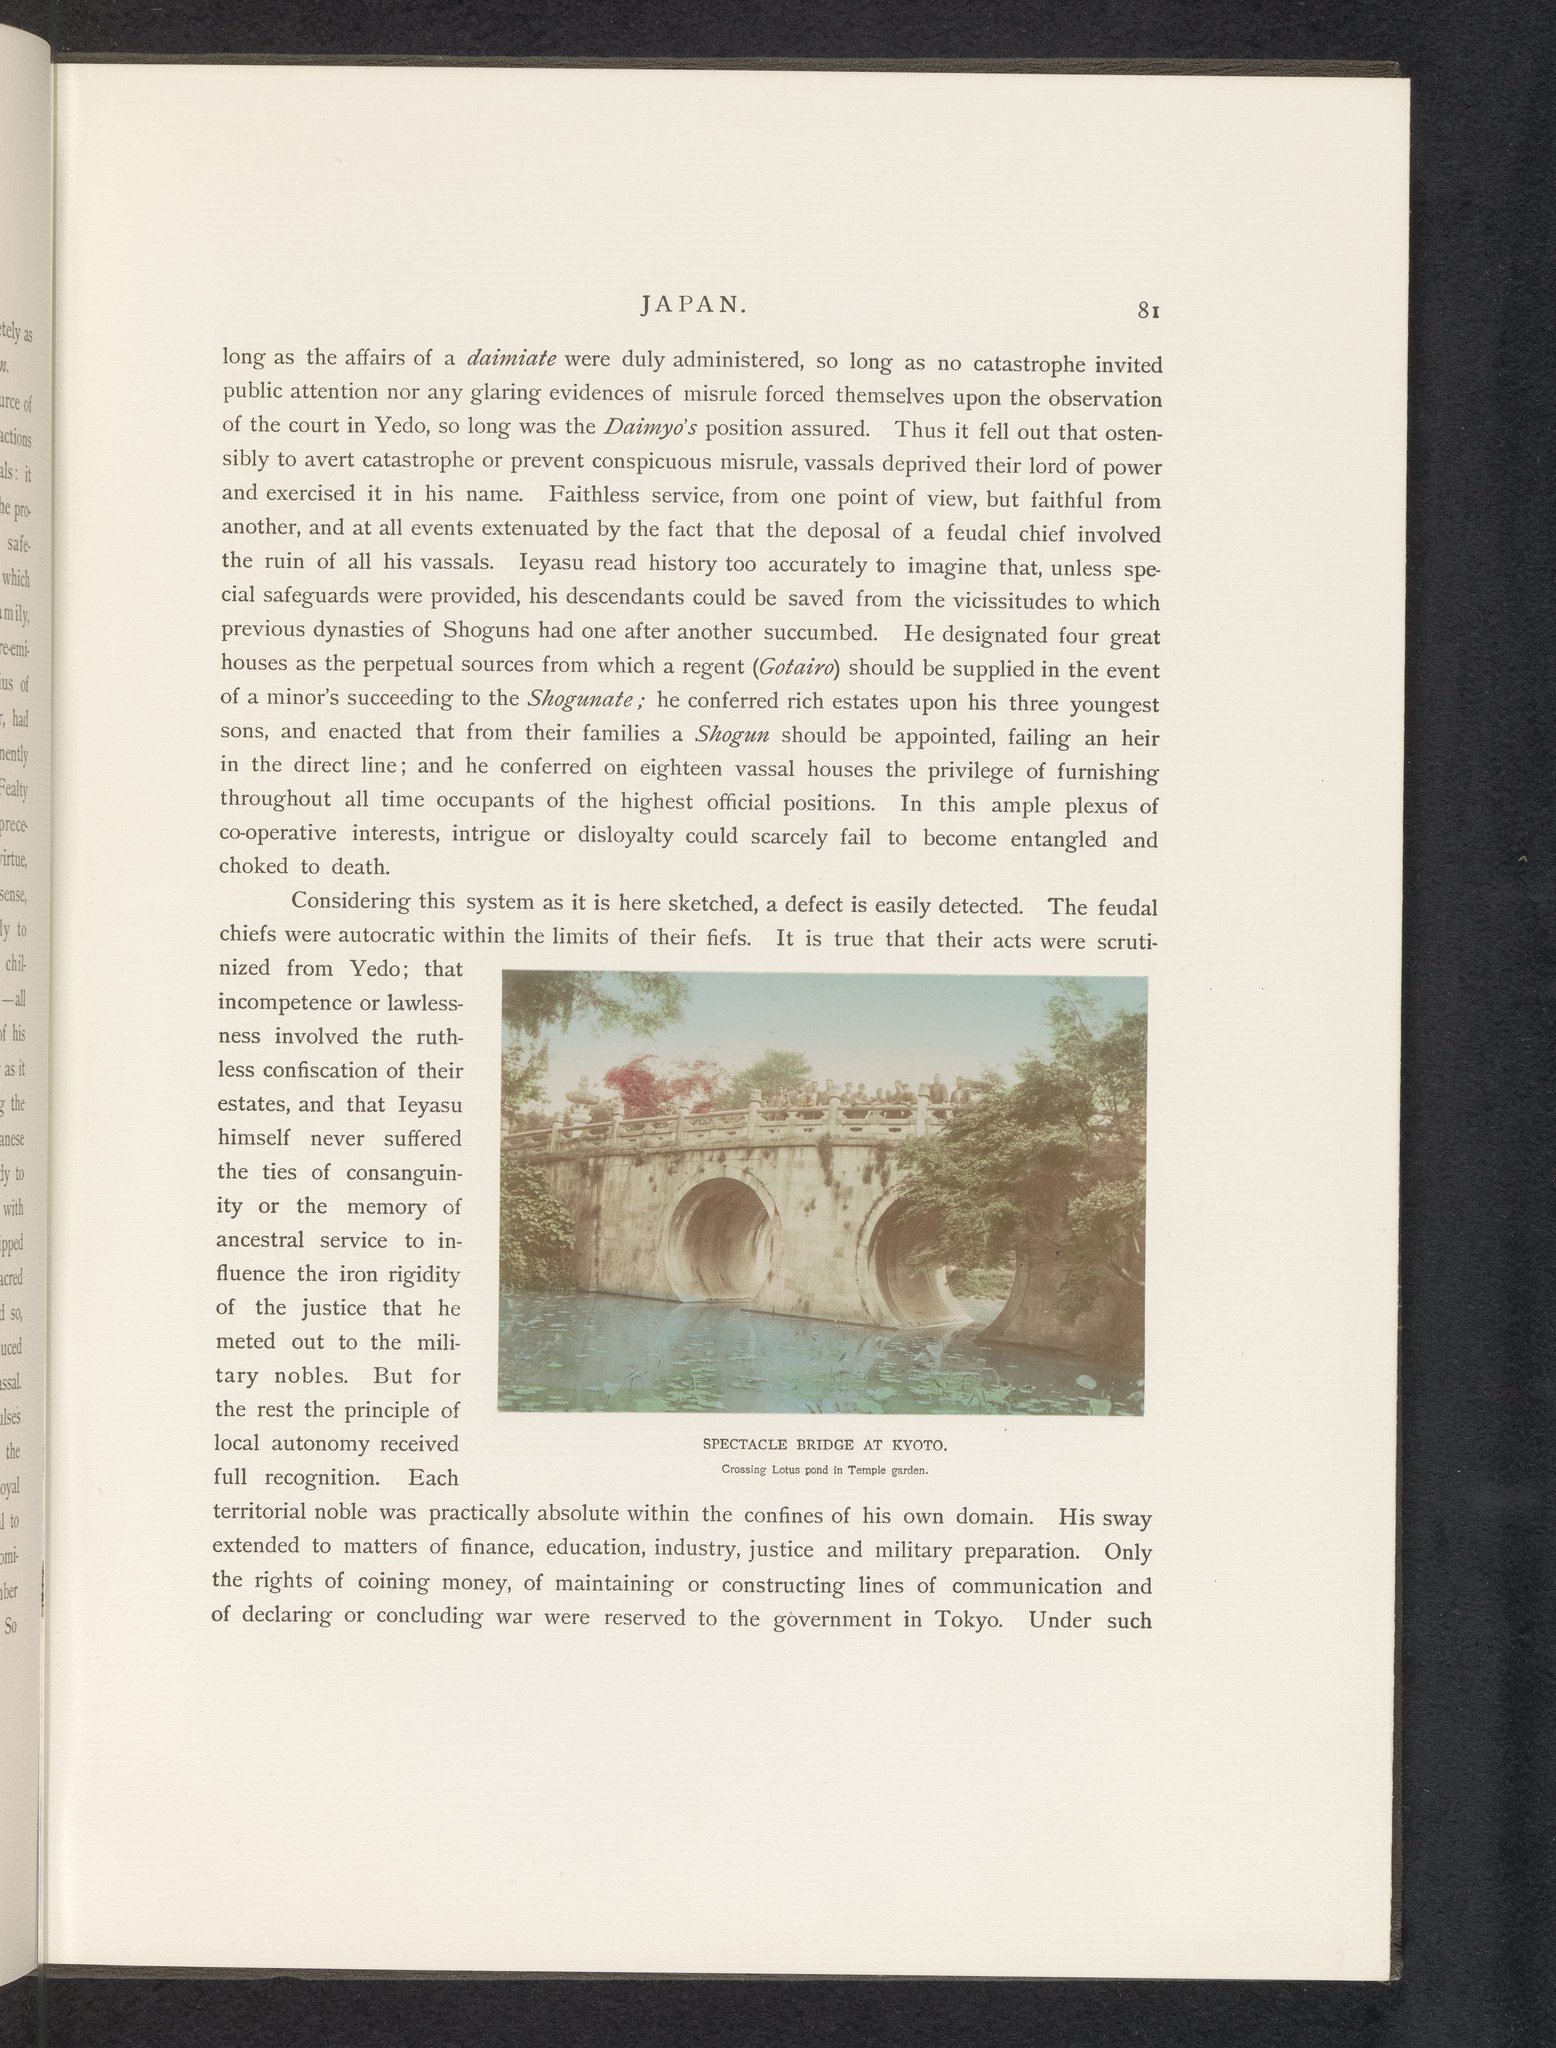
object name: page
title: Spectacle bridge at Kyoto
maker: Anonymous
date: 1887-1897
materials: photographic support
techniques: albumen print, hand coloring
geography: japan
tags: pond, pool, bridge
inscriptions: inscription: ‘Crossing Lotus pond in Temple garden.’